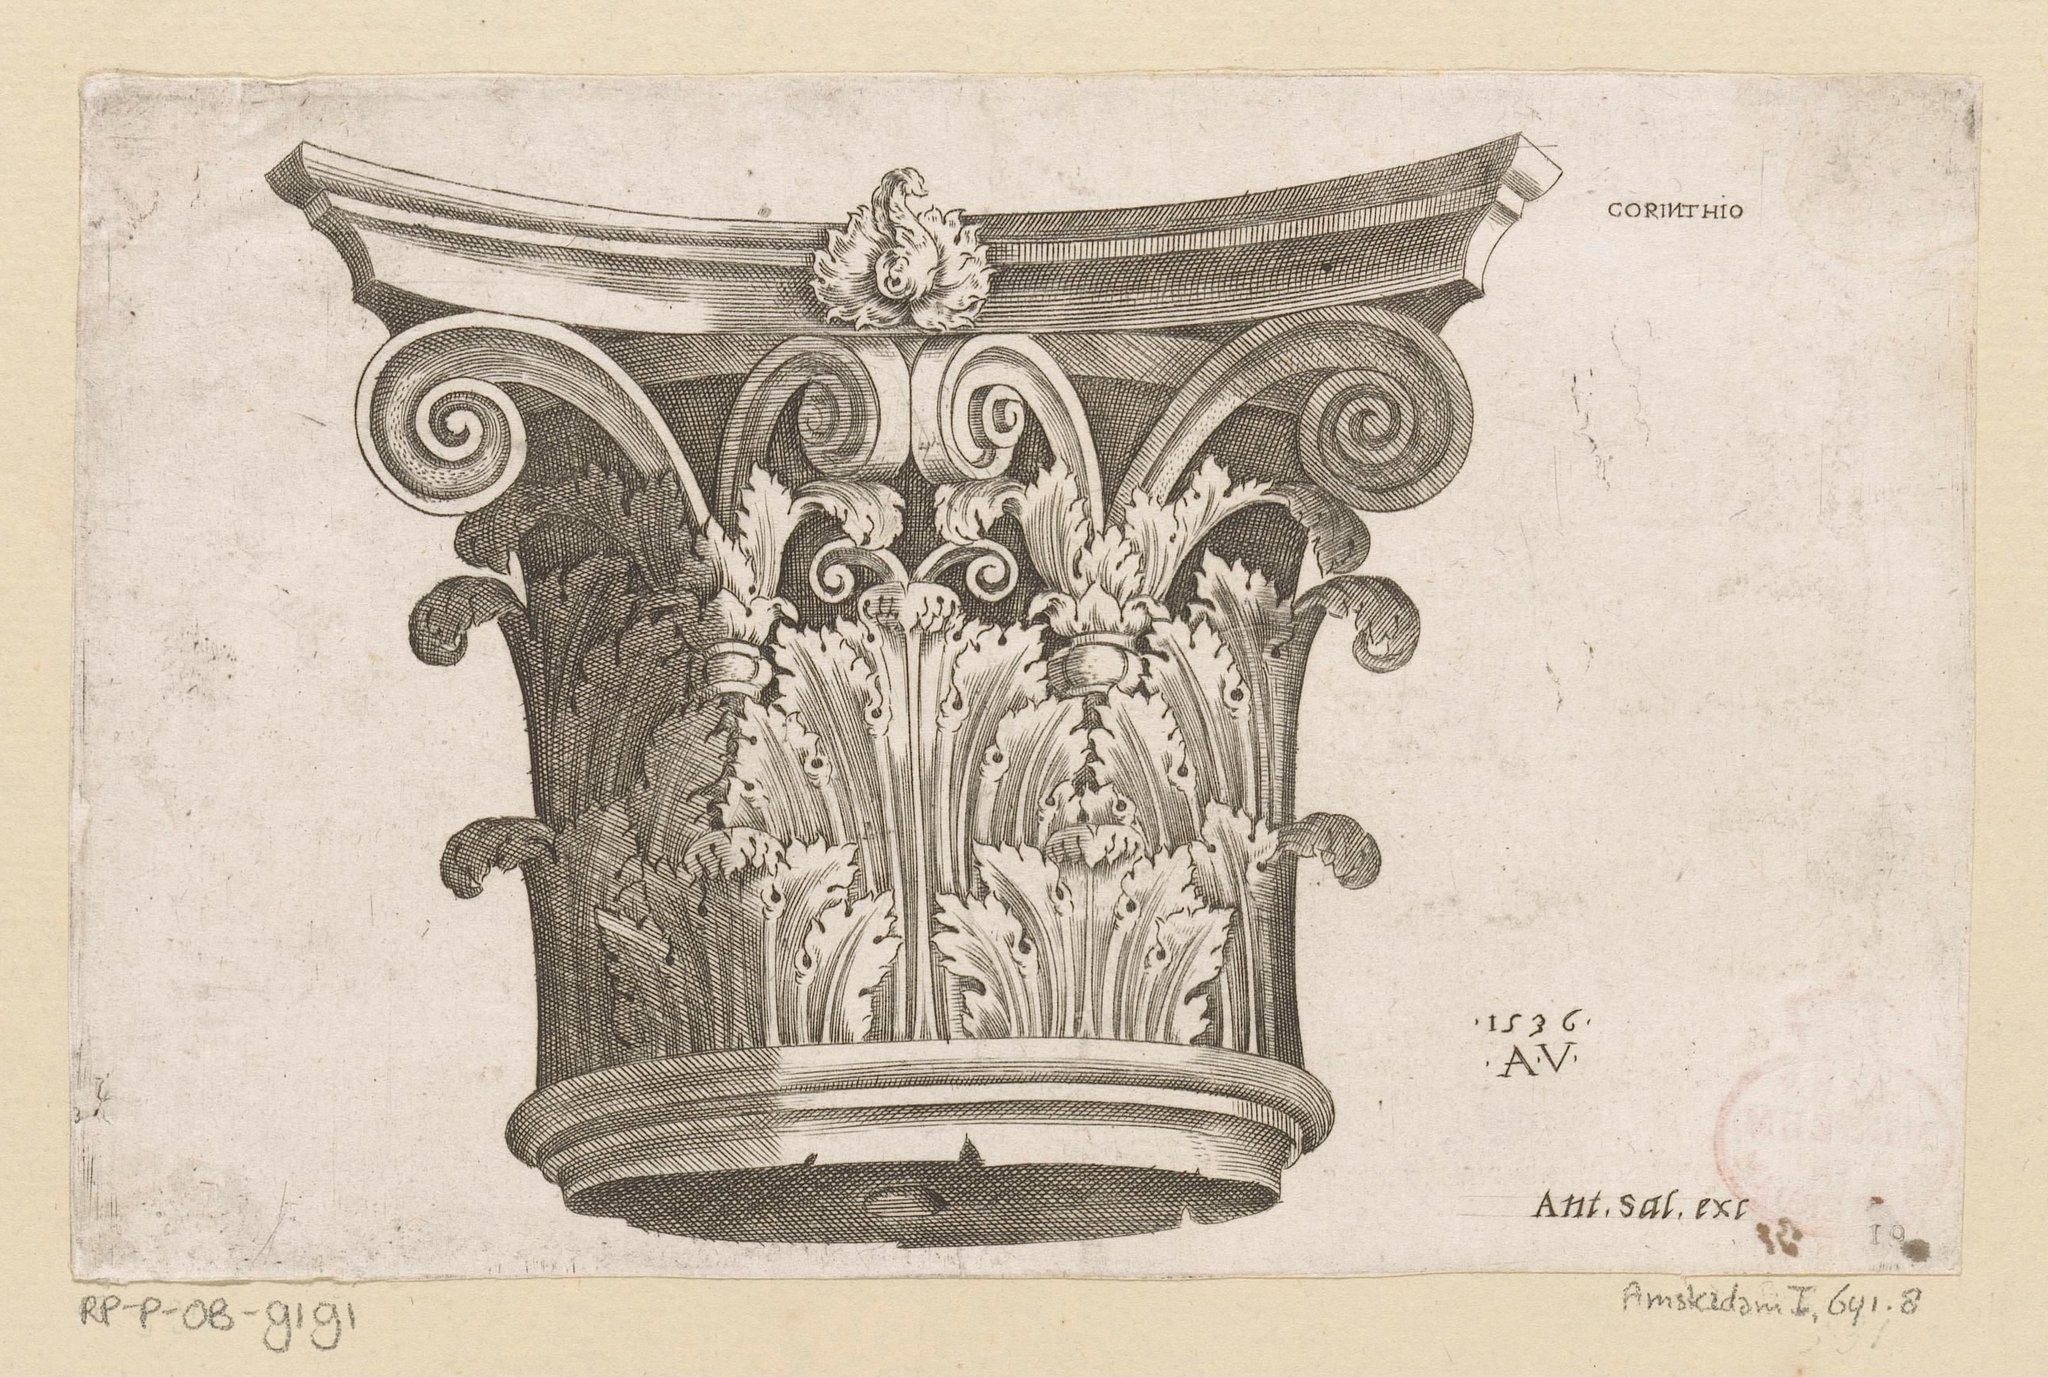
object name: print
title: Korinthisch kapiteel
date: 1536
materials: paper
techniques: engraving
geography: italy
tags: capital (~ column, pillar)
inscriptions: collector's mark: Lugt 12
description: Deze prent maakt deel uit van een reeks van negen prenten met antieke bouwfragmenten. De nummering op de prenten wijkt af.